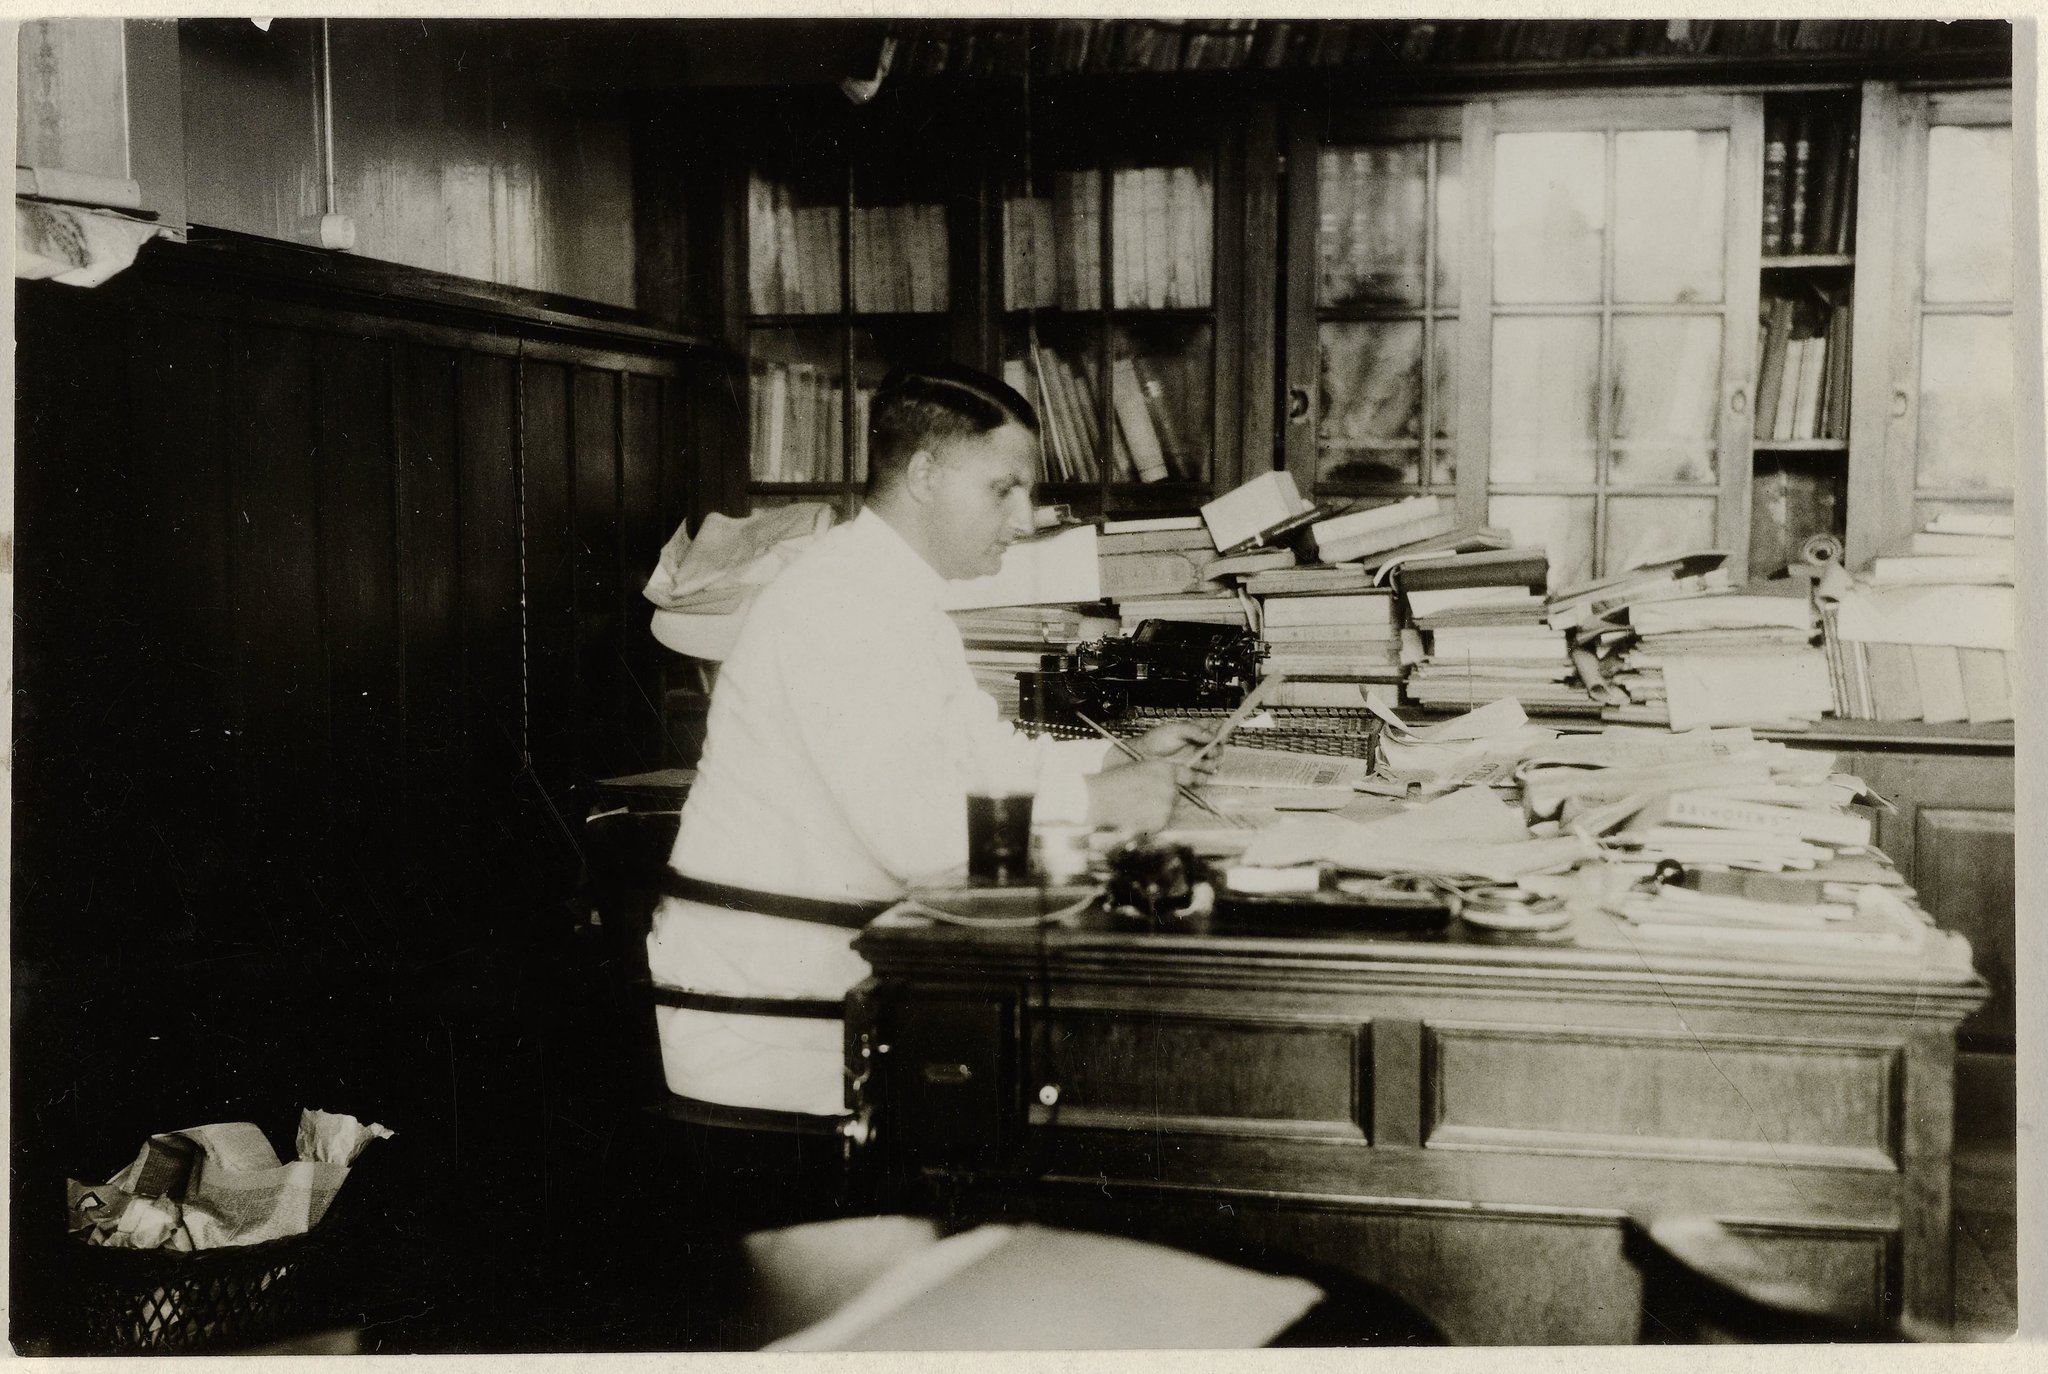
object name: photograph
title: Man achter een bureau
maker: Anonymous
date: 1900-1935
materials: photographic support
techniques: collodion silver print, gelatin silver print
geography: medan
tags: dutch east indies, the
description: Een man achter een bureau in een kantoor van de Deli Courant. Onderdeel van een groep van 49 losse zwart-wit foto's van verschillend formaat over de uitgeverij en drukkerij van de krant Deli Courant in Medan in de periode 1885-1947.